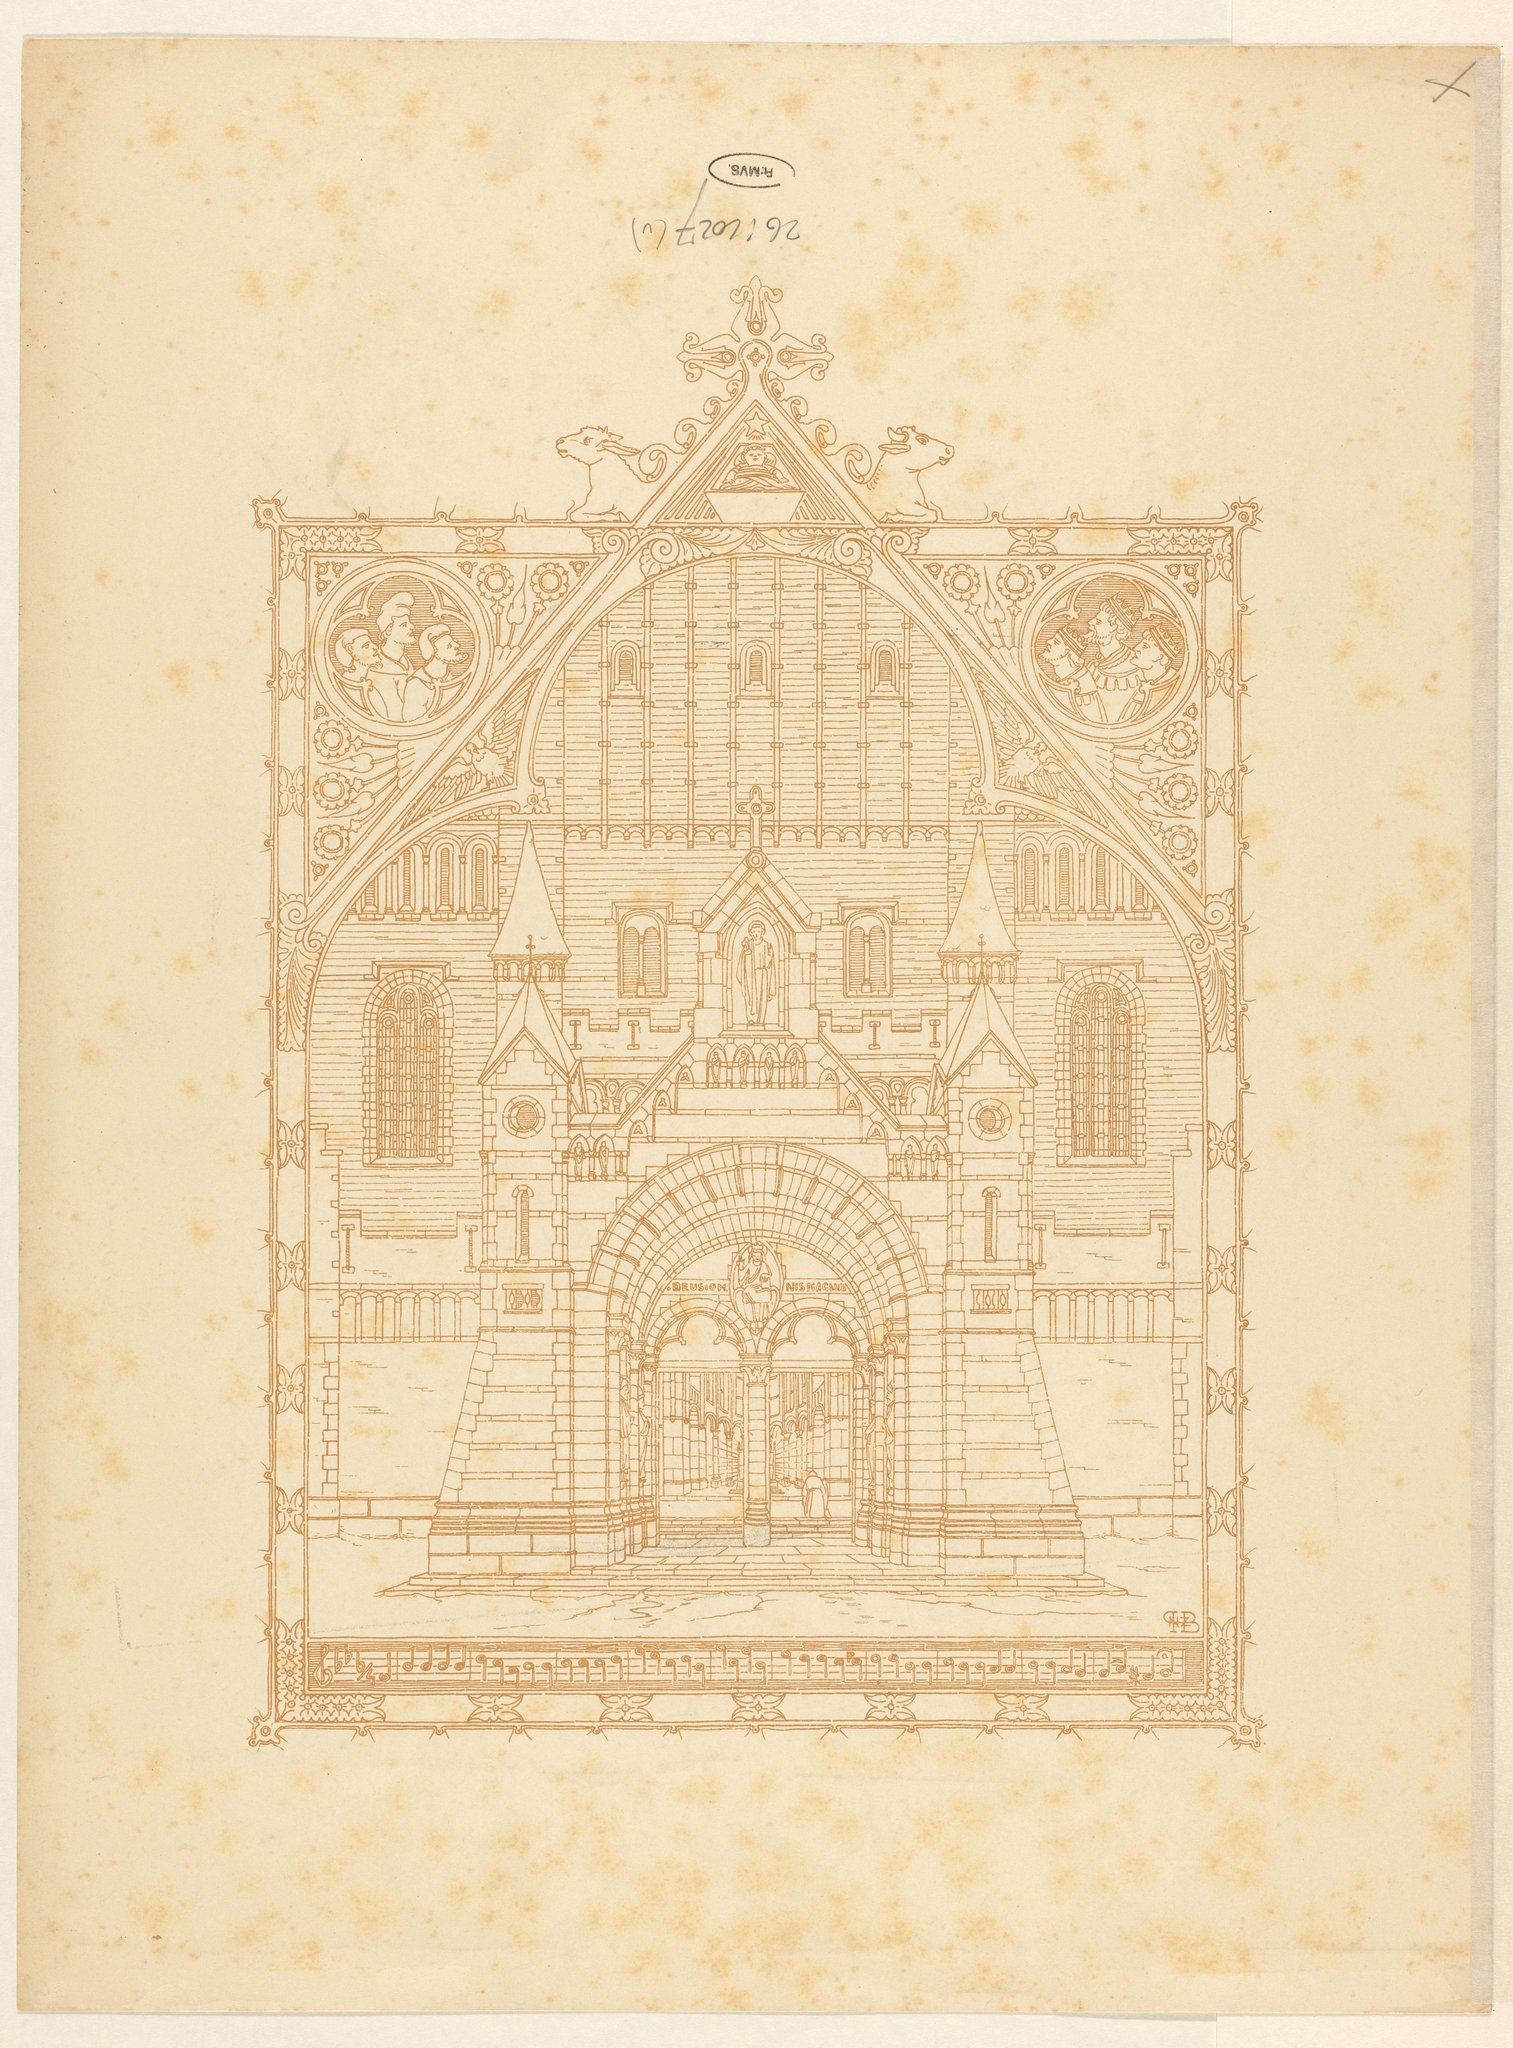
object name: print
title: Kerkportaal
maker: Anonymous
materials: paper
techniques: lithograph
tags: parts of church exterior and annexes: porch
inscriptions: collector's mark: Lugt 2228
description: Kerkportaal met open deuren. Boven het portaal de tekst Deus Omnis Magnus. Het portaal is gevat in een ornamentele omlijsting met notenbalk aan de onderzijde.